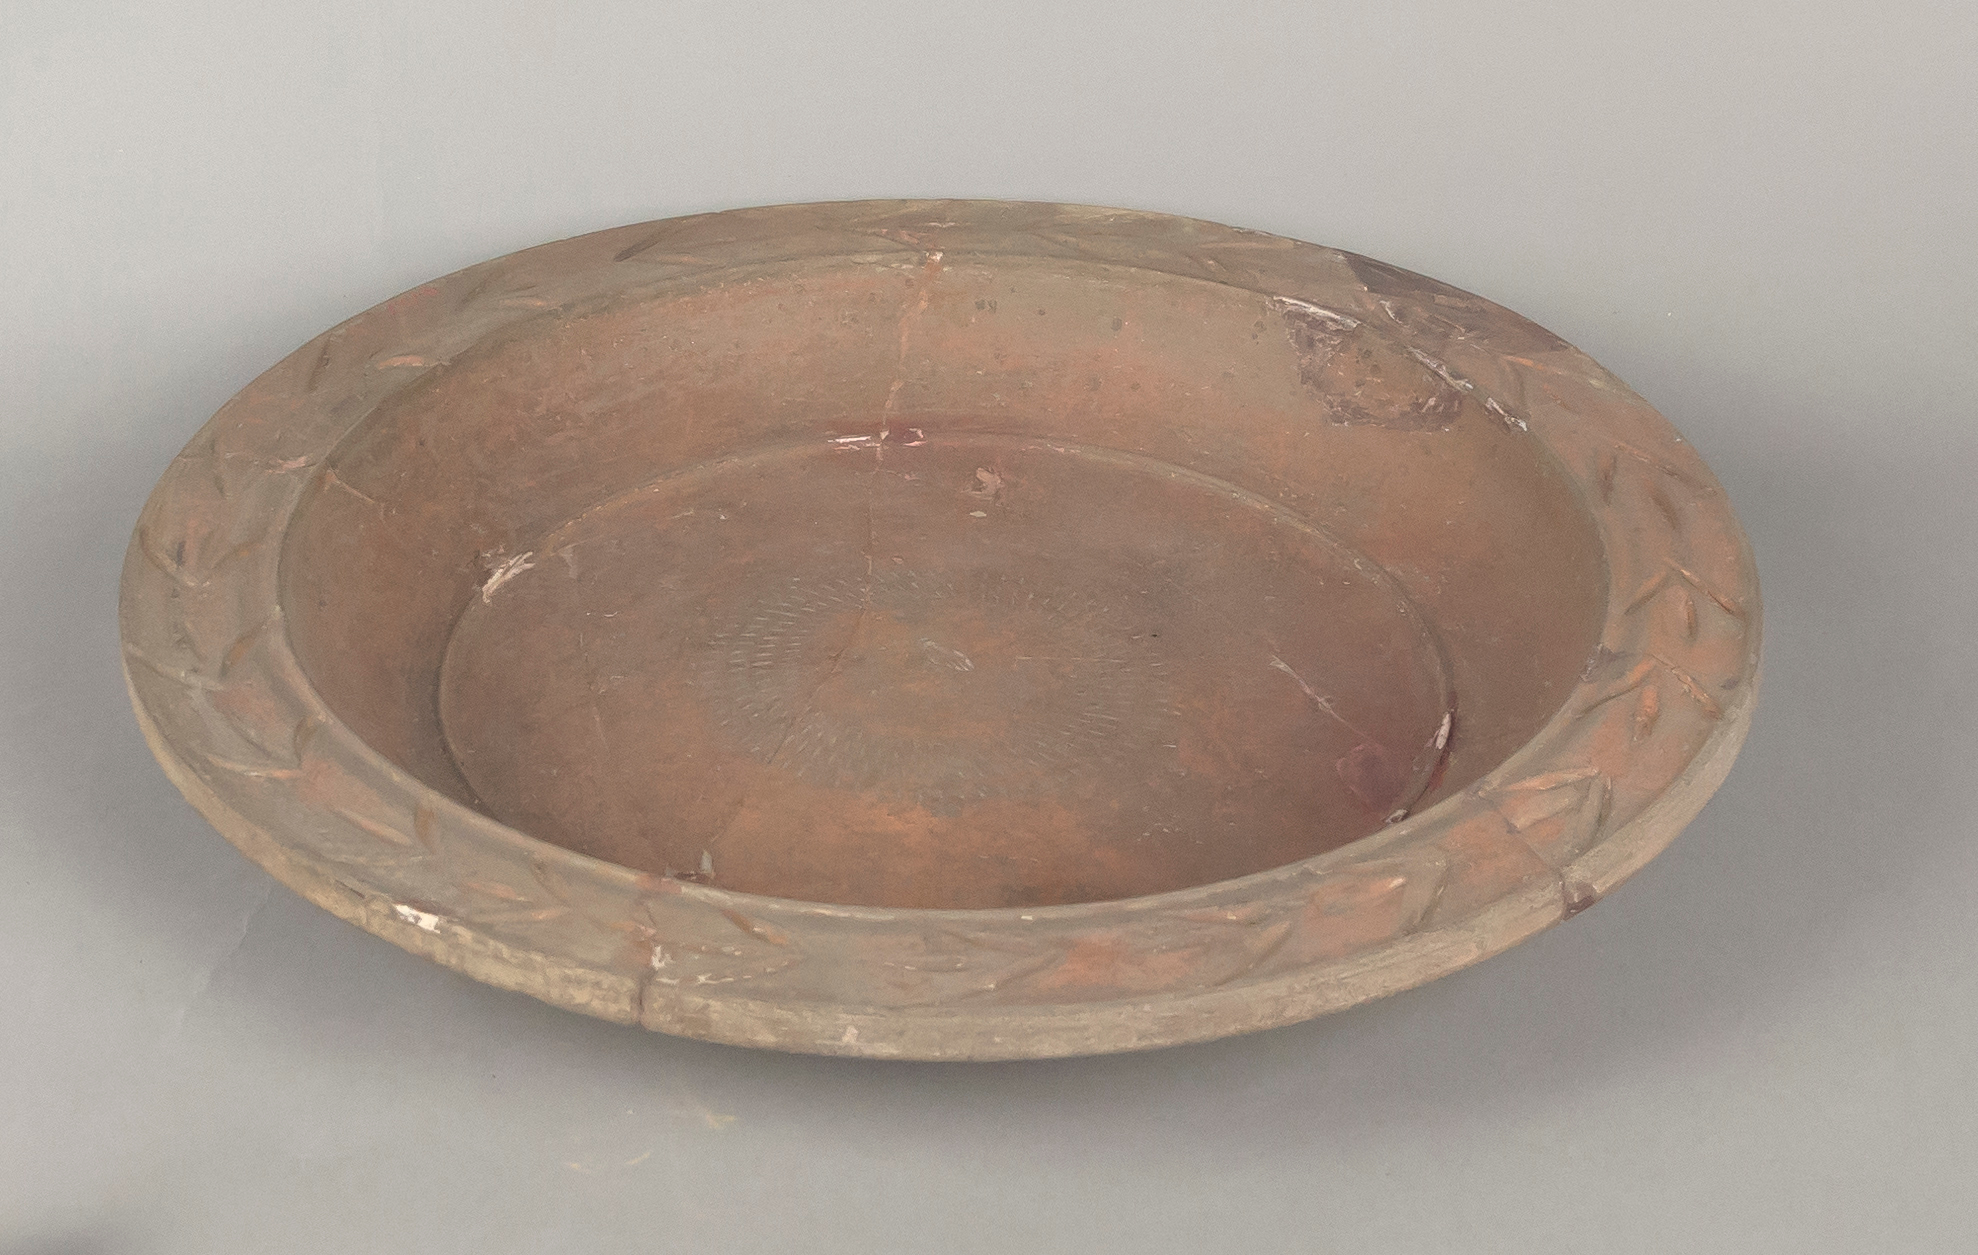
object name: plate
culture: greek or lydian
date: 900-30 BCE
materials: terracotta